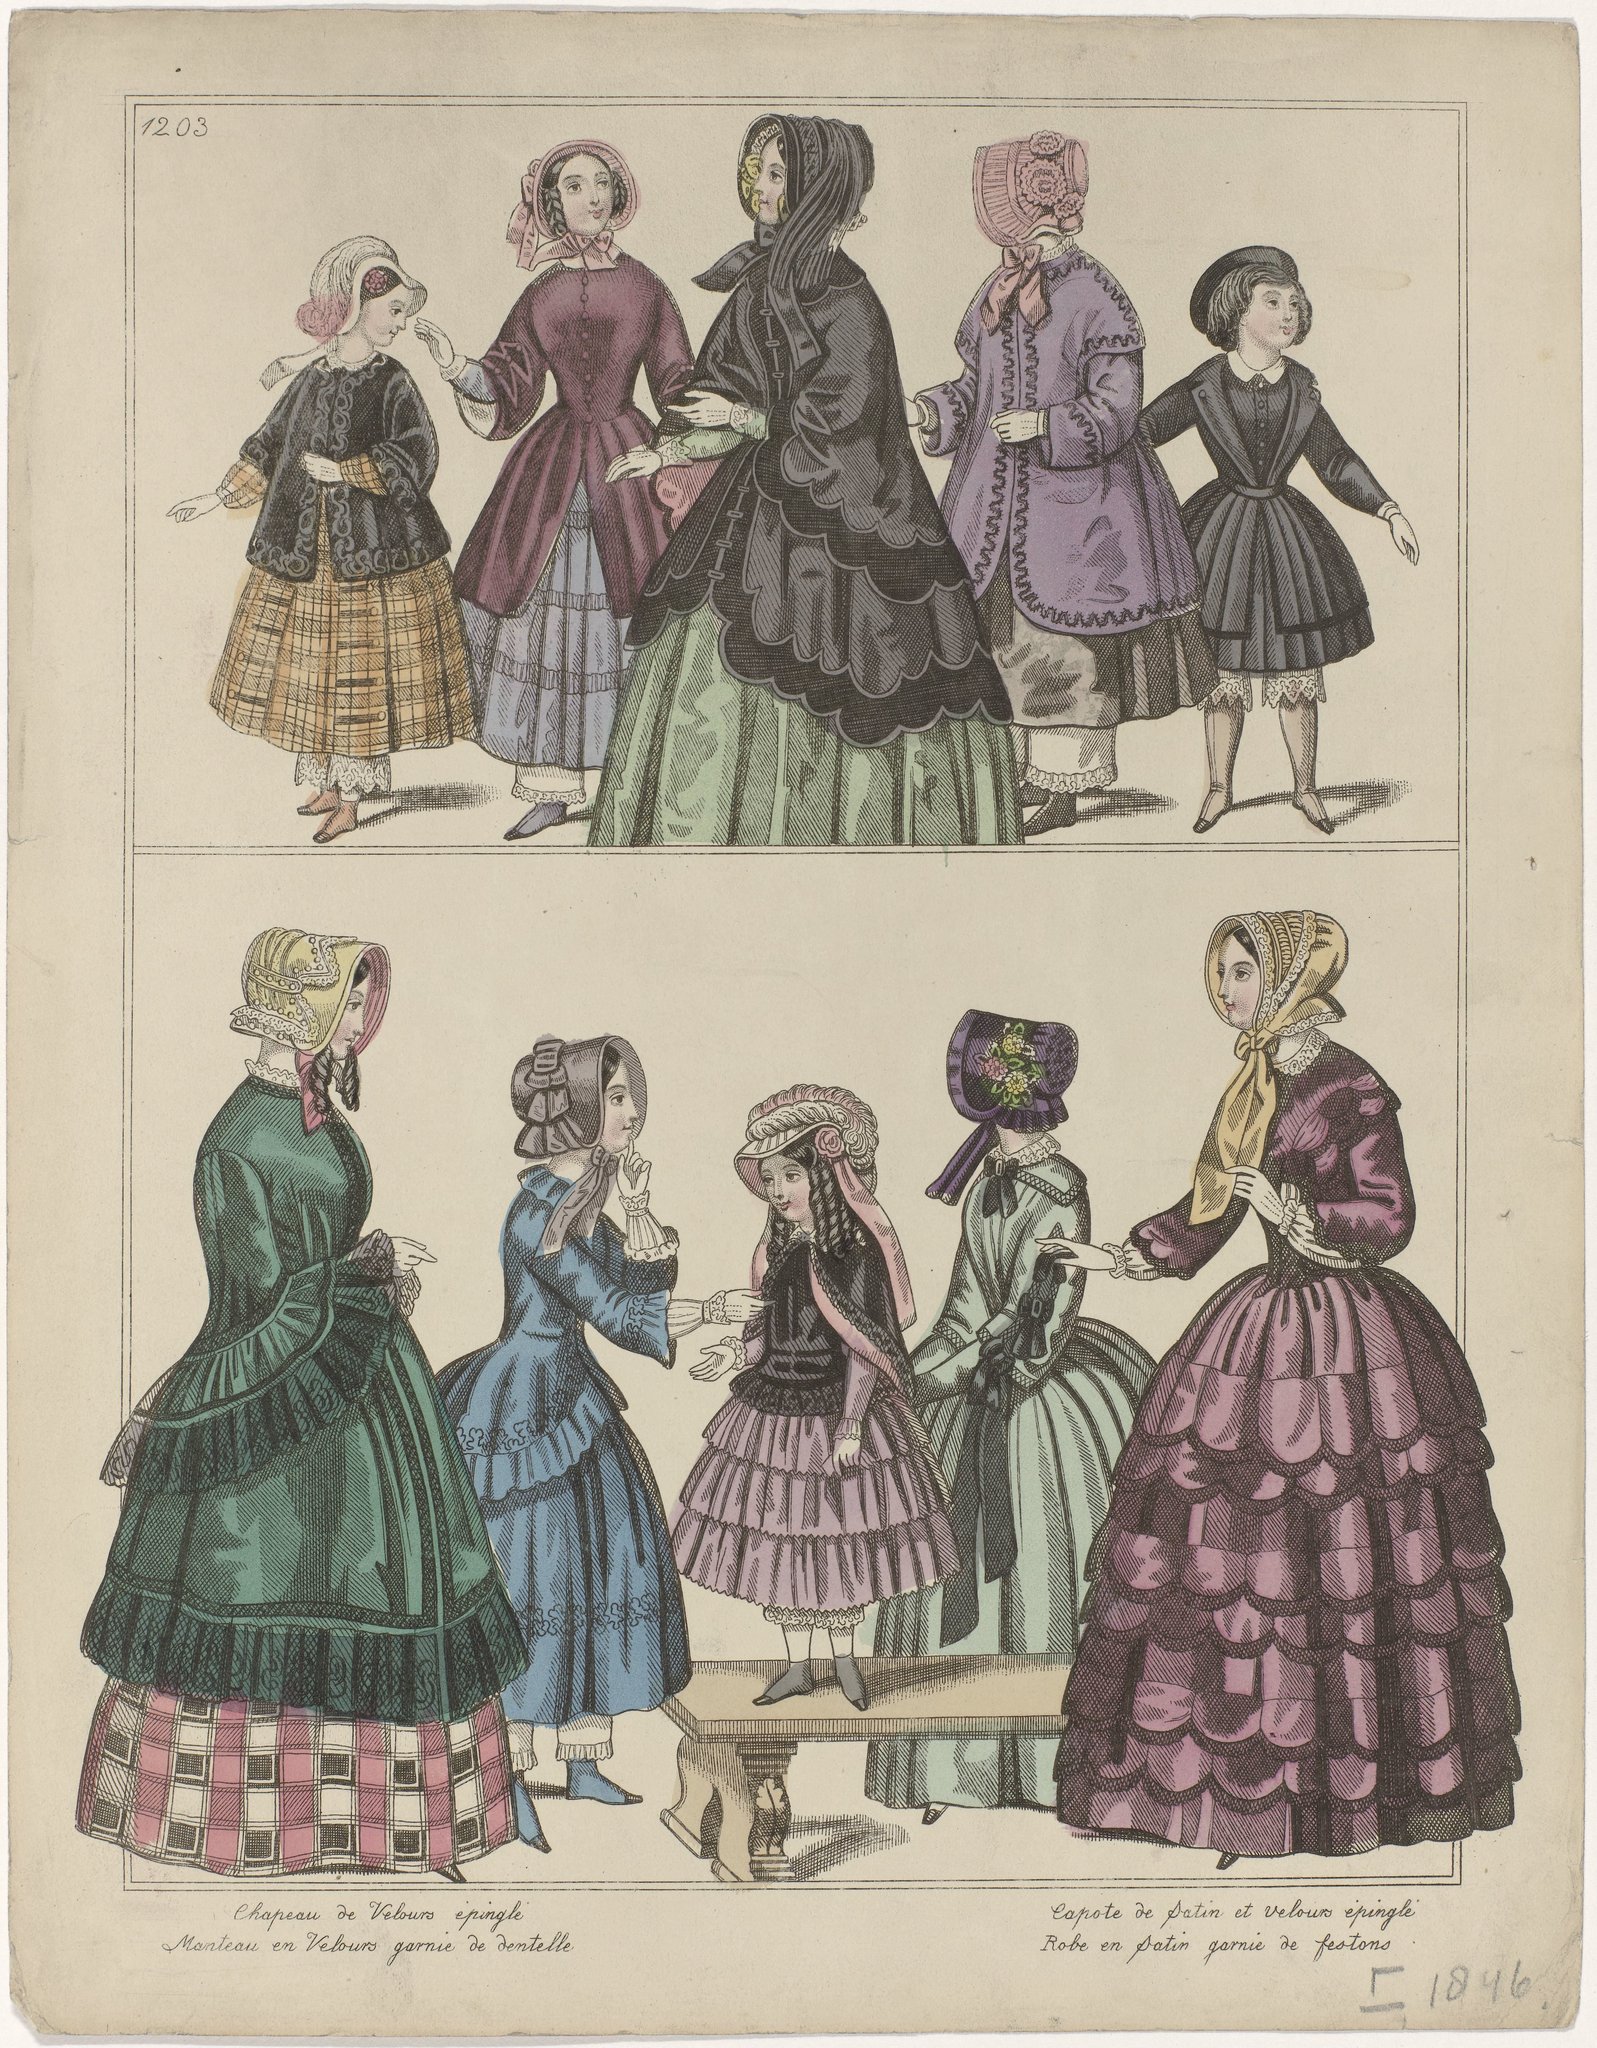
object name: fashion print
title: Townsend's Monthly Selection of Parisian Costumes, 1846, No. 1203 : Chapeau de Velours (...)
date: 1846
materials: paper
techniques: engraving, hand coloring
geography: london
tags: skirt (+ girls' clothes), head-gear (capote) (+ women's clothes), border, ribbon, braid (+ women's clothes), head-gear: hat (+ girls' clothes), ornamental parts of clothing (+ lace used for clothes), underclothes for the lower part of the body: bloomers (+ girls' clothes), coat (+ women's clothes), coat (+ girls' clothes), fashion plates, head-gear: hat (+ women's clothes), dress, gown (+ women's clothes)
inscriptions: caption: ‘Chapeau de Velours épinglé Manteau en Velours garnie de dentelle. / Capote de satin et velours épinglé Robe en satin garnie de festons.’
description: In het bovenste kader vier meisjes met 'bloomers' en een vrouw met mantel. In het onderste kader een vrouw met hoed van 'velours épinglé '. Mantel van fluweel versierd met kant op een geruite rok. De vrouw rechts heeft een 'capote' van satijn en 'velours épinglé'. Japon van satijn versierd met festons. Tussen hen in staan drie meisjes, waarvan één op een bank. Prent uit het modetijdschrift Townsends Monthly Selection of Parisian Costumes (London 1823-1888).